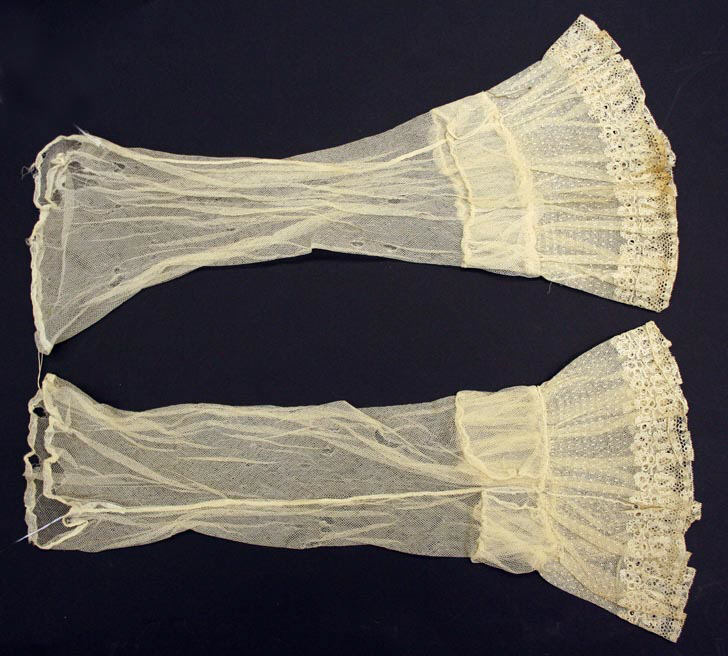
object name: undersleeves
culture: american or european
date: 1860